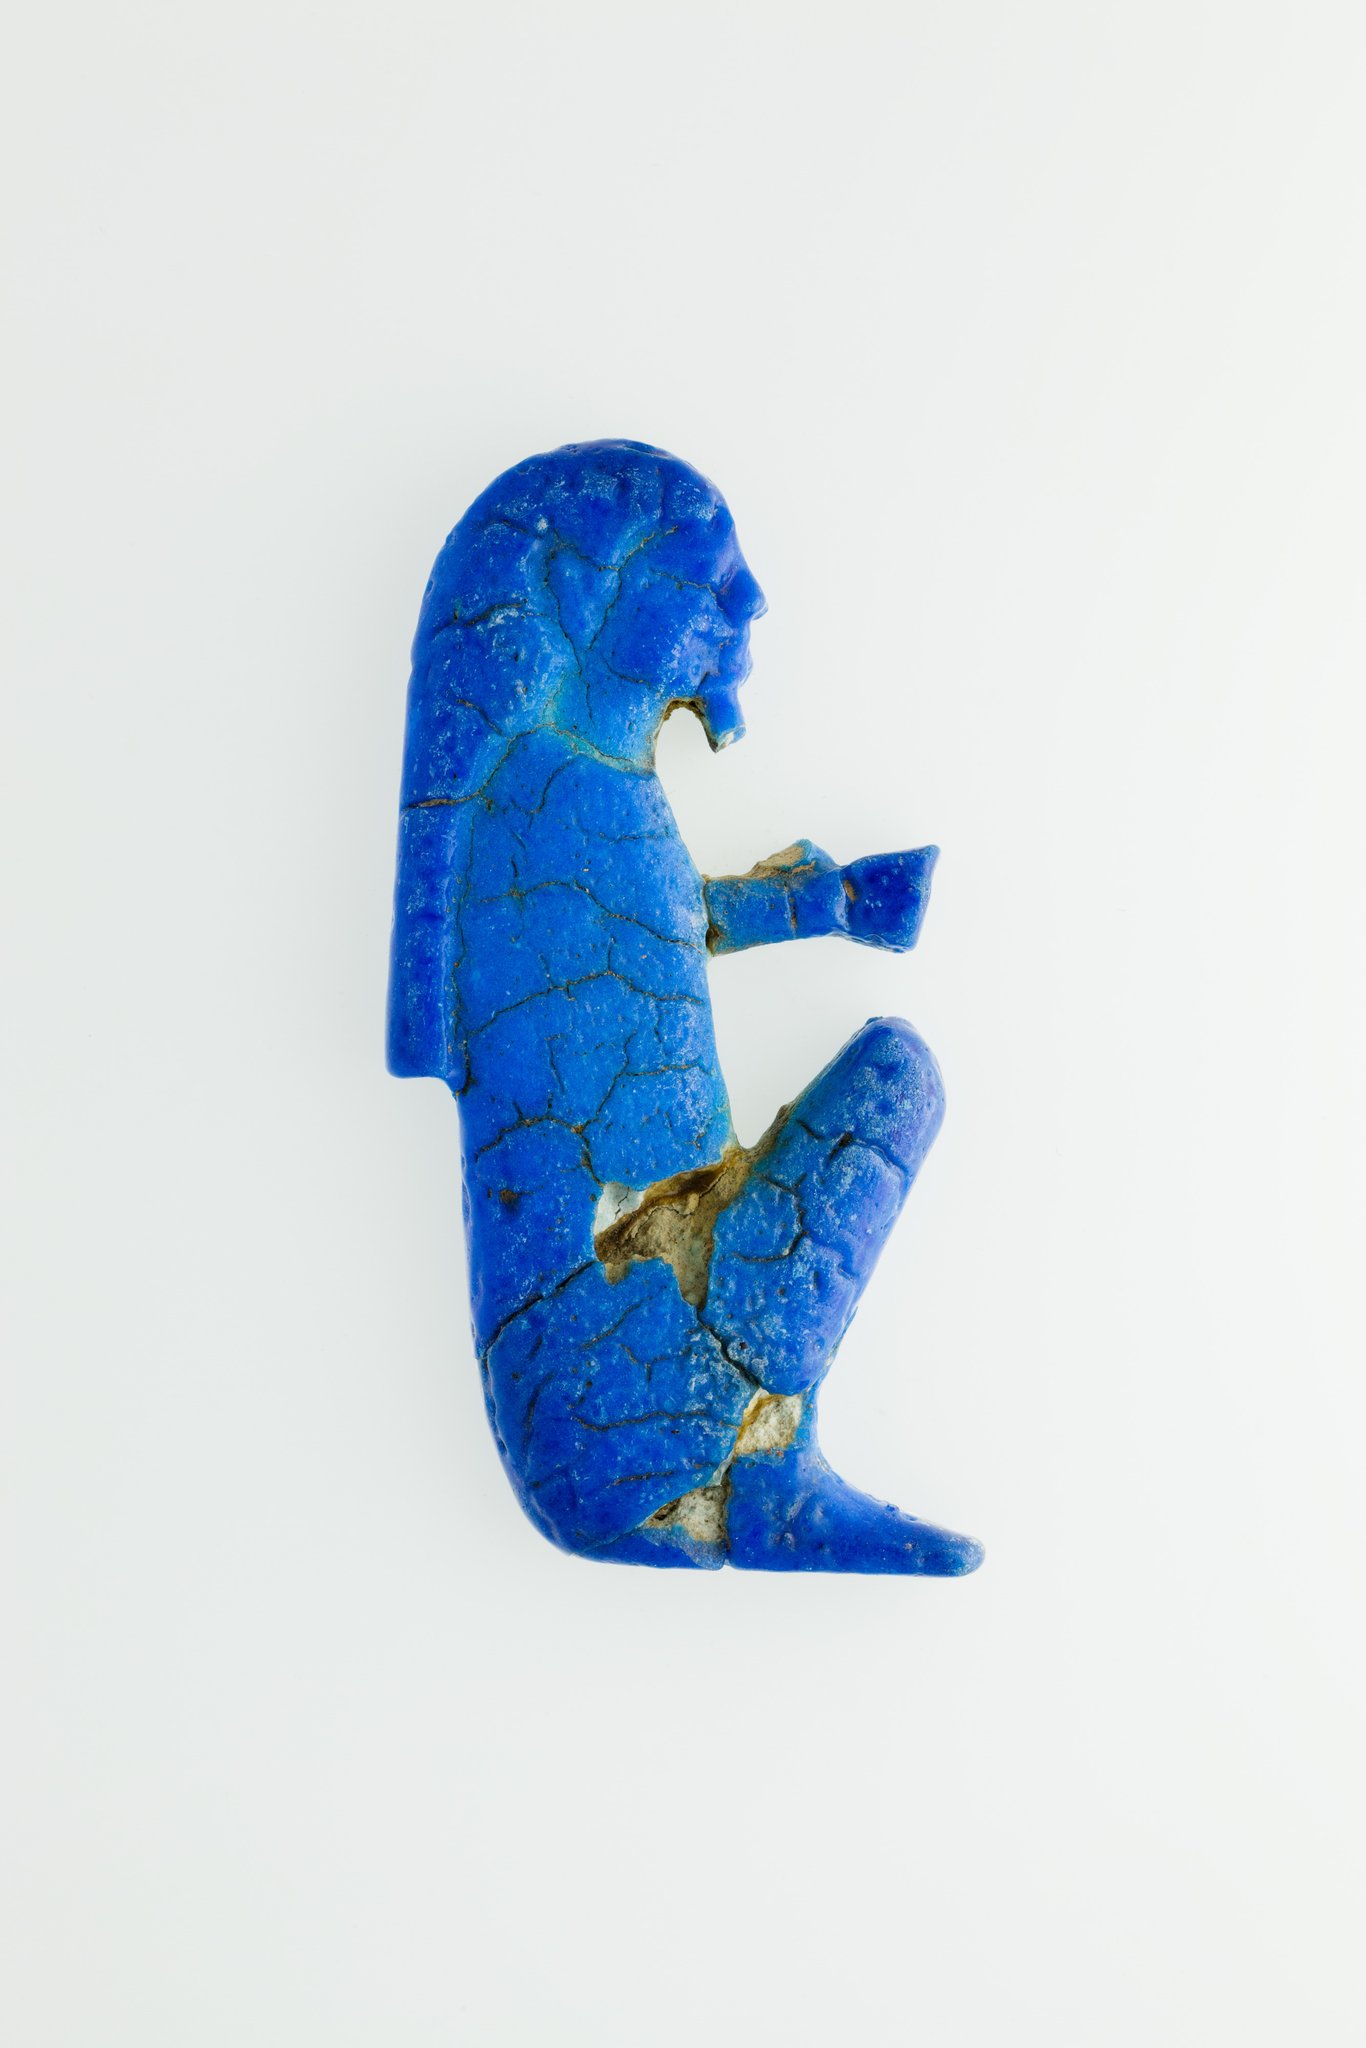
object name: inlay, hieroglyph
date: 664-610 BCE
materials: faience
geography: egypt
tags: men